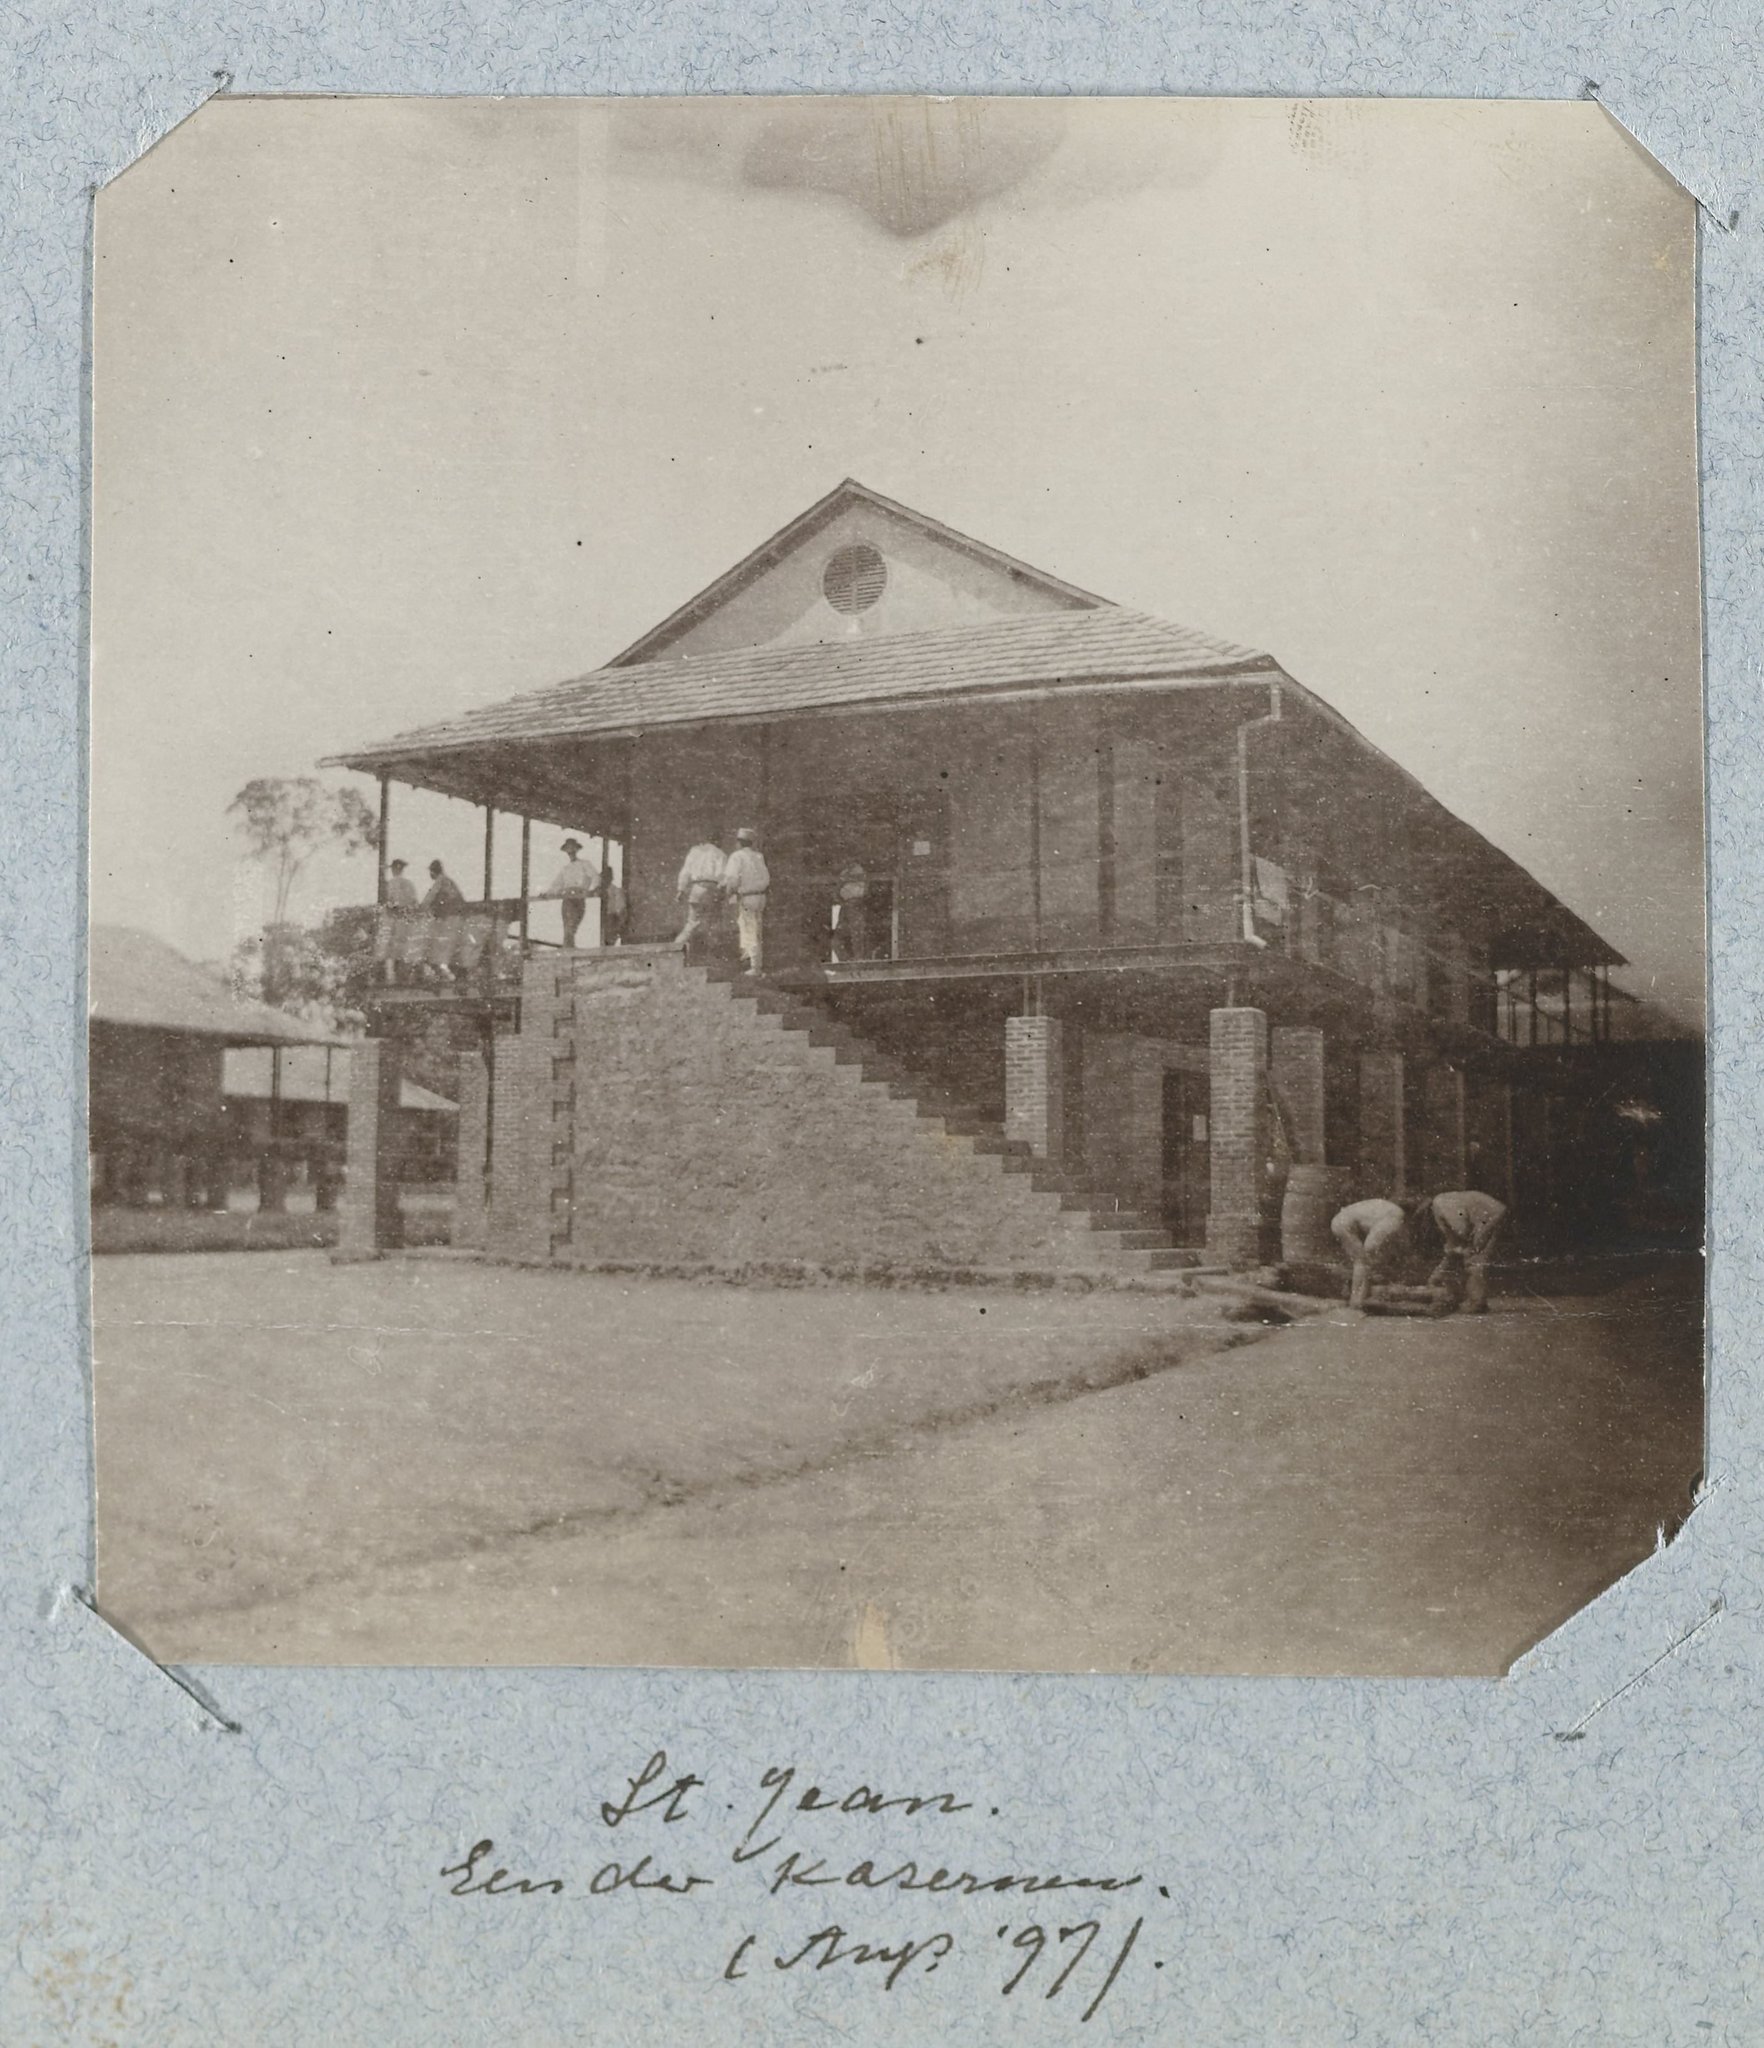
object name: photograph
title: St. Jean. Een der kazernen (Augs. '97)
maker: théodore van lelyveld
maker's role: painter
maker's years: 1867-1954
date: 1808-1897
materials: photographic support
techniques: collodion silver print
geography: suriname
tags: workhouse, penal camp, penitentiary, chain gang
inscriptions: inscription: ‘St. Jean. Een der kazernen (Augs. '97)’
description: Een van de kazernes in de Franse strafkolonie te St. Jean (Saint-Jean-du-Maroni) in Guyana, augustus 1897. Fotoafdruk in een fotoalbum van Théodore van Lelyveld over Suriname uit 1895-1898.